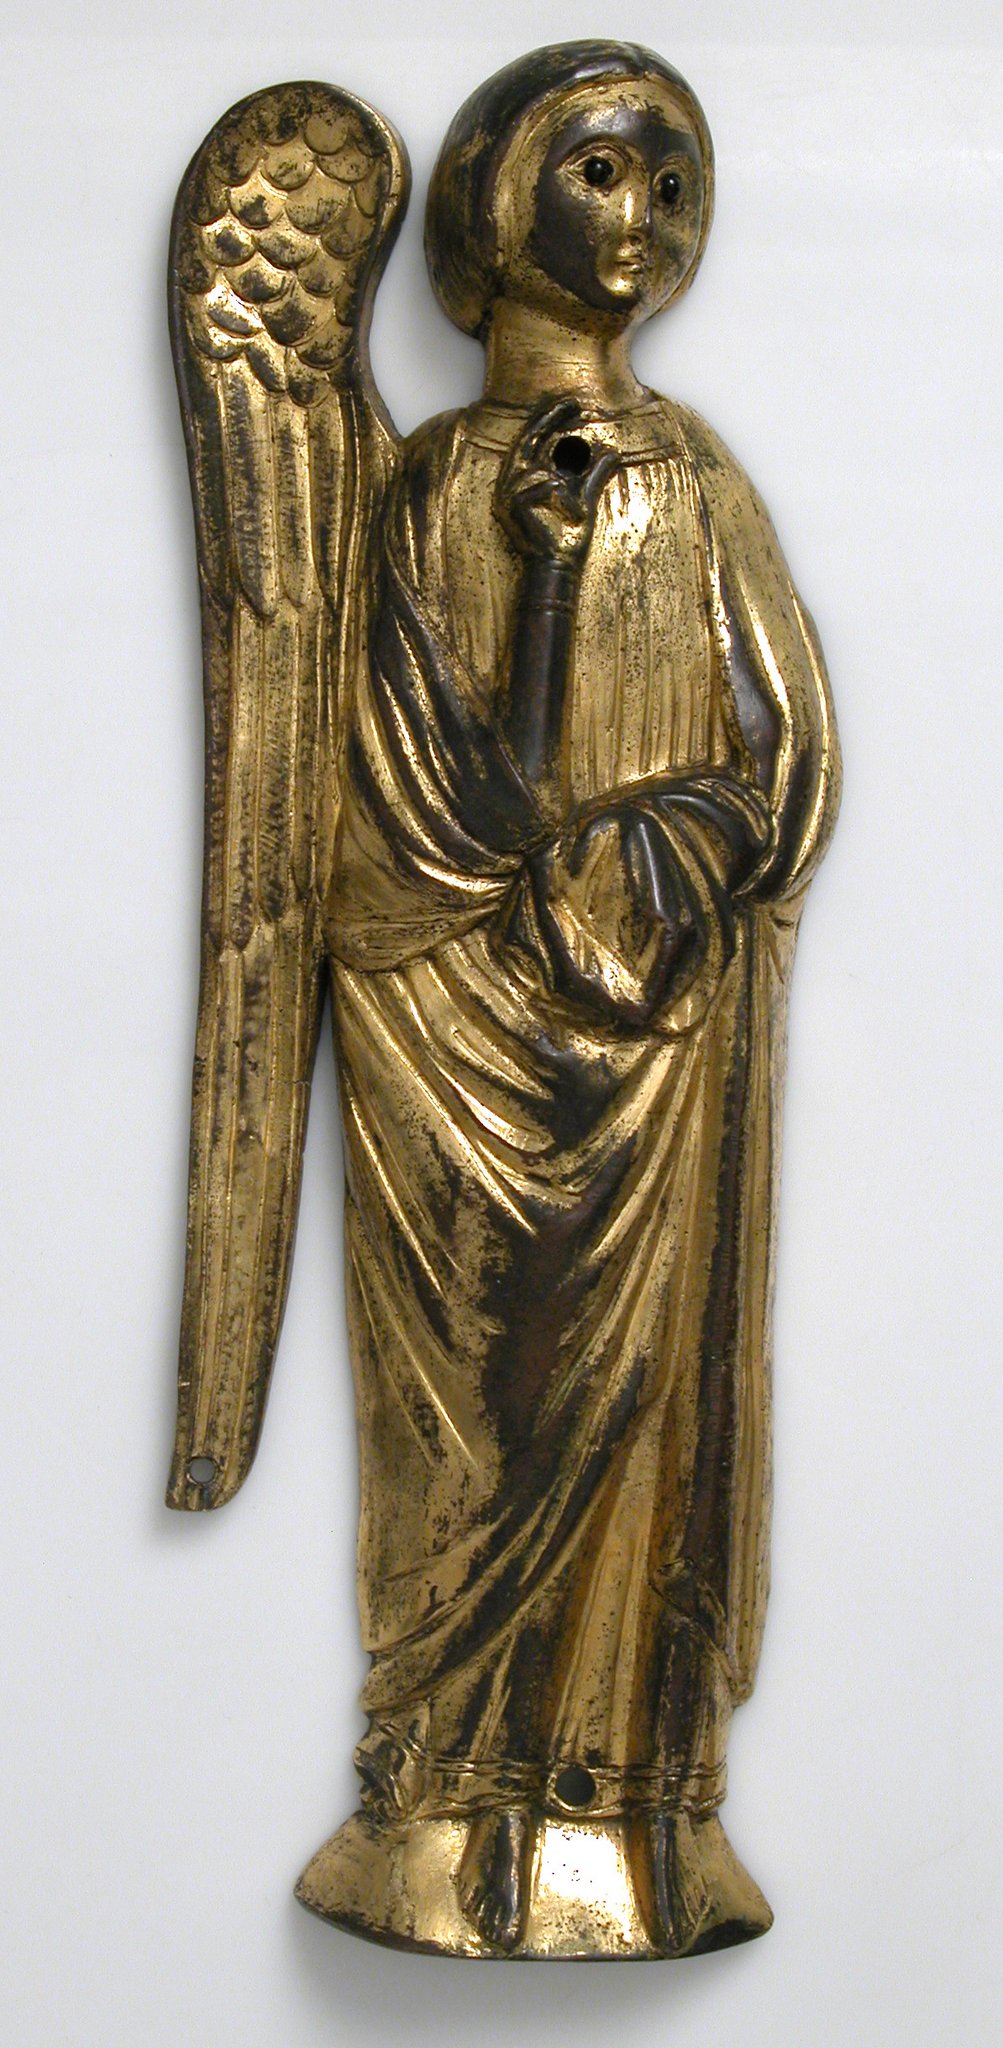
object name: appliqué figure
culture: french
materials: gilt copper, glass, paste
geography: france